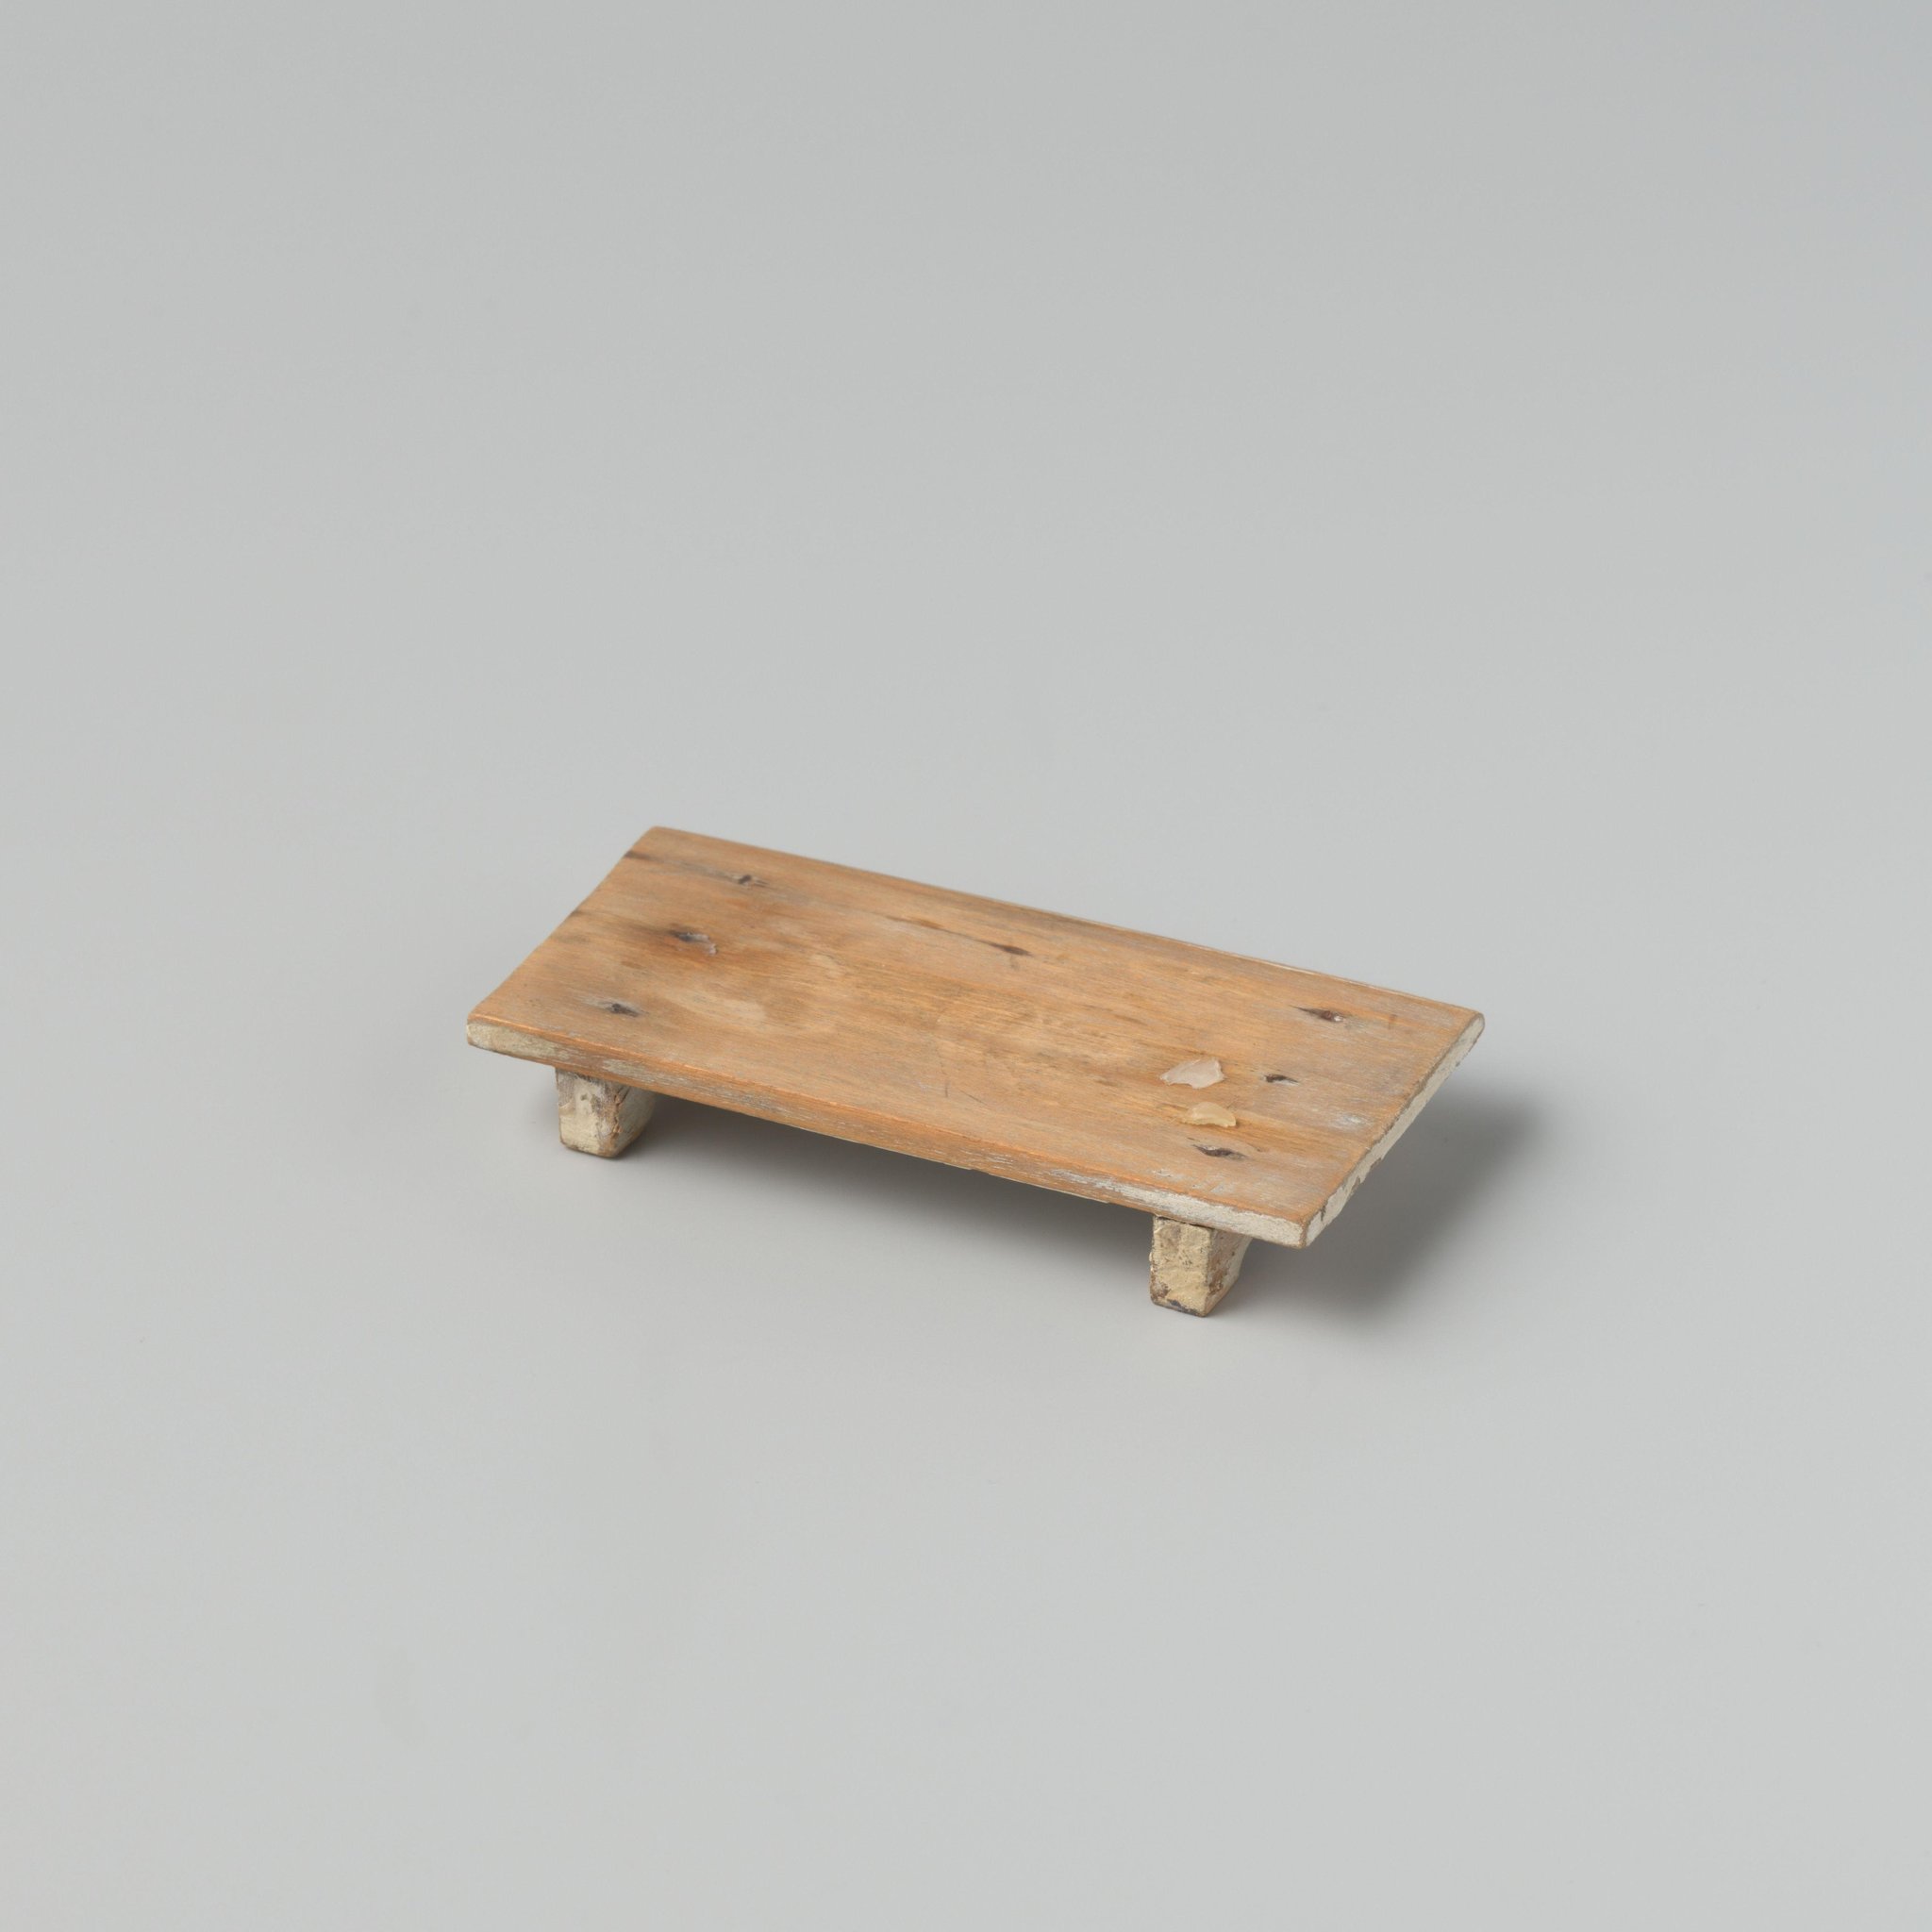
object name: miniature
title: Vlonder of laagbankje van een wit gesausd withoutsoort; bestaande uit alleen aan de voorzijde geprofileerde plank, rustend op twee dwarsplankjes met accolade versiering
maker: Anonymous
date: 1690-1710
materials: wood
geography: amsterdam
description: Vlondr of laag bankje, vervaardigd van een wit gesausde withoutsoort; bestaande uit alleen aan de voorzijde geprofileerde plank, rustend op twee dwarsplankjes met accolade versiering.